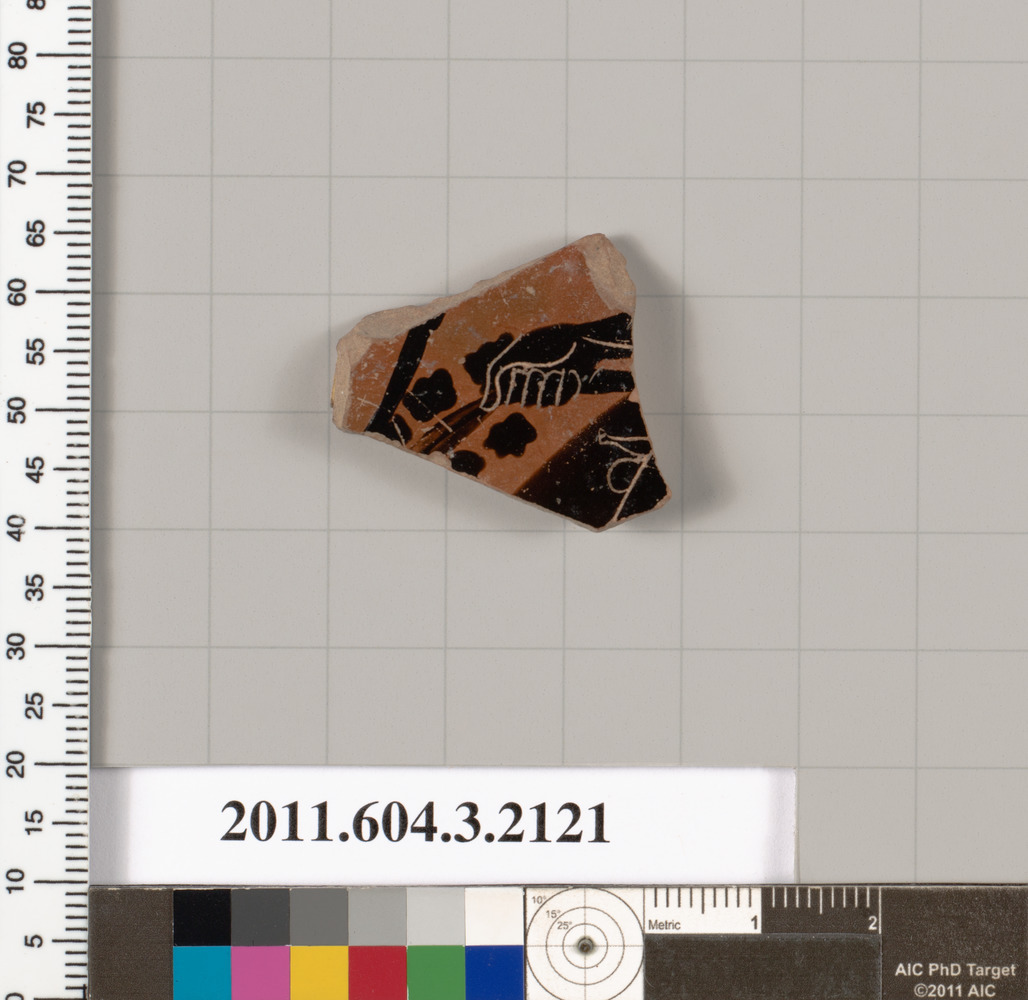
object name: kylix fragment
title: Terracotta fragment of a kylix (drinking cup)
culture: greek, attic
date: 525-501 BCE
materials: terracotta